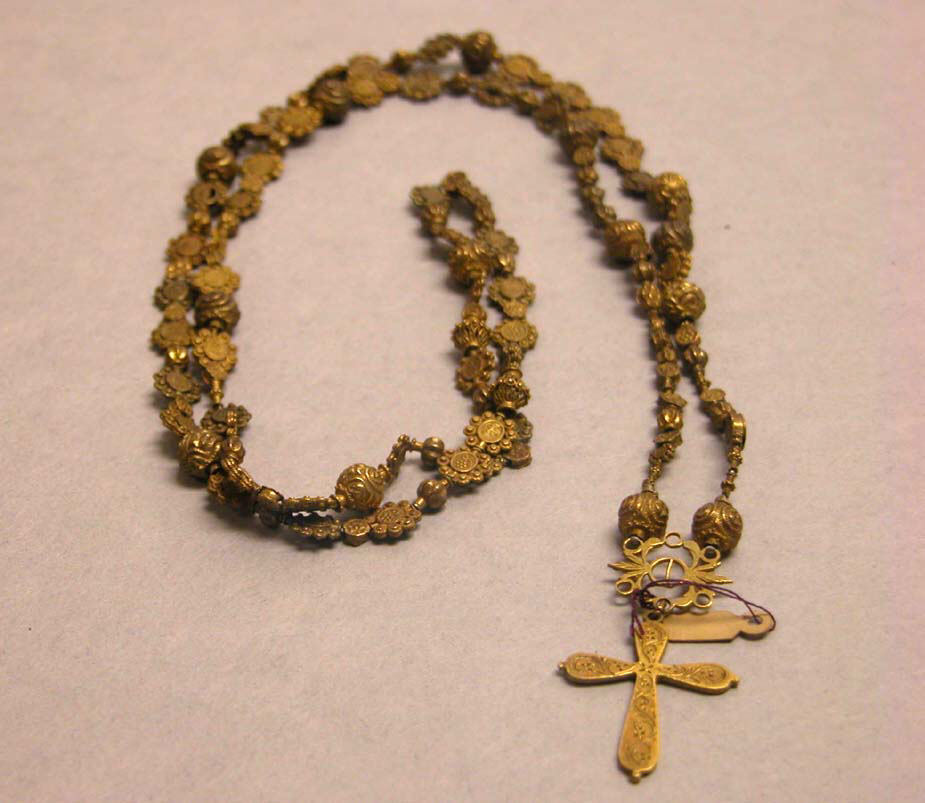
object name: rosary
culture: filipino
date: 1601-1900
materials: gold